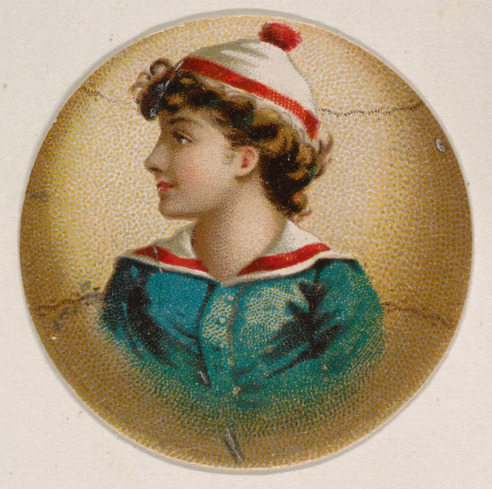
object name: print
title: Baseball, from the Novelties series (N228, Type 3) issued by Kinney Bros.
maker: kinney brothers tobacco company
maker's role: publisher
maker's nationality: american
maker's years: 1869-2011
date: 1889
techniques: color lithograph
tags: profiles,women